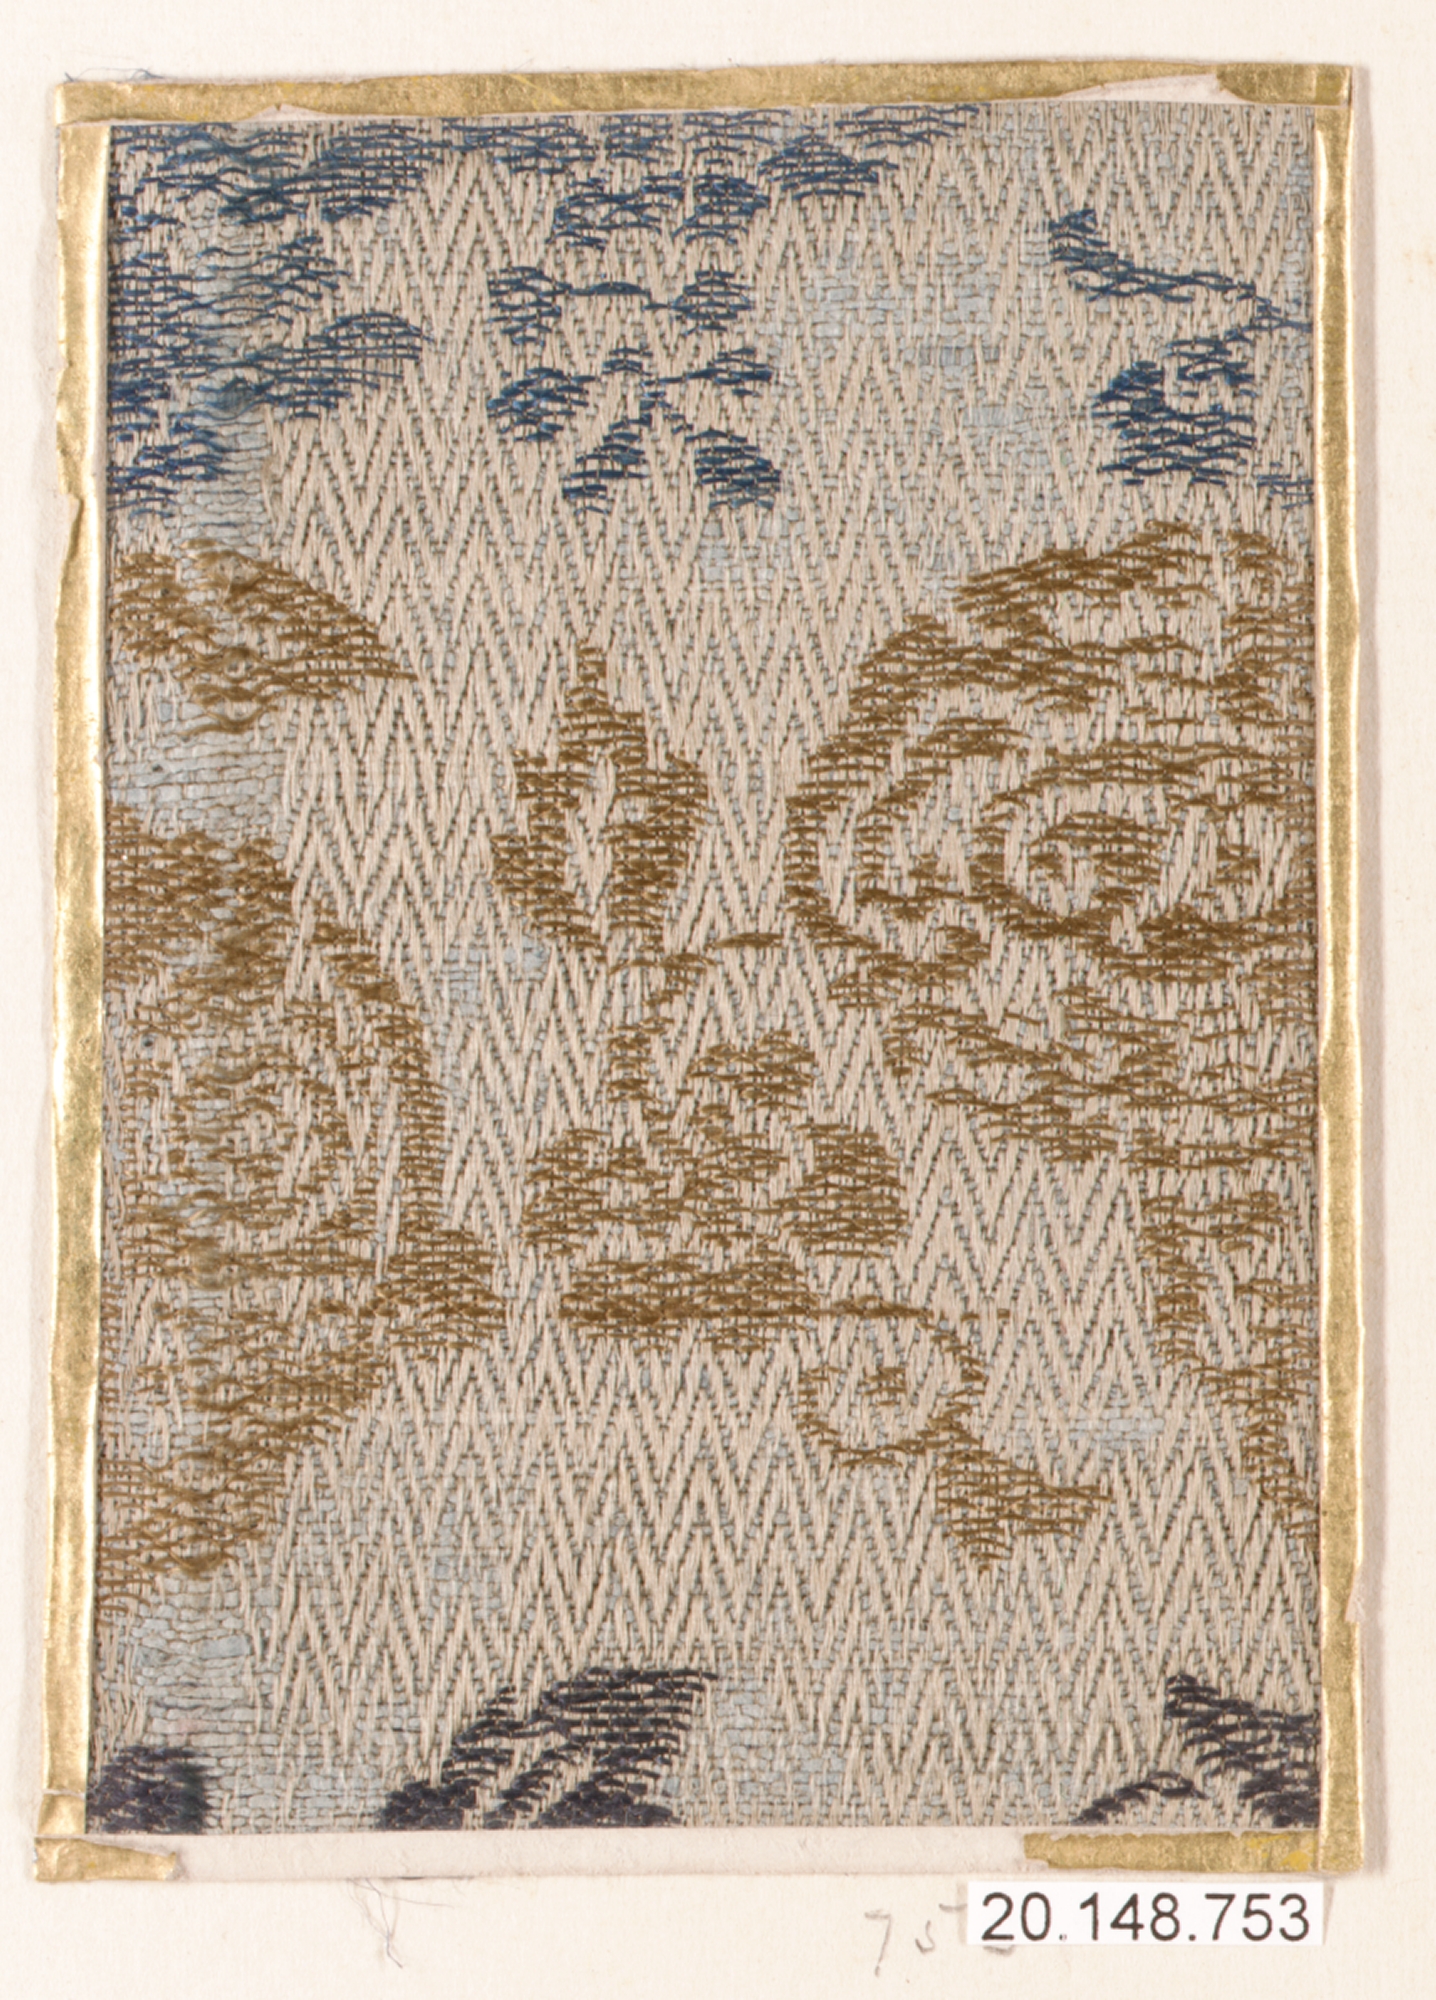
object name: piece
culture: japanese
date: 1801-1900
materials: silk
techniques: compound weave